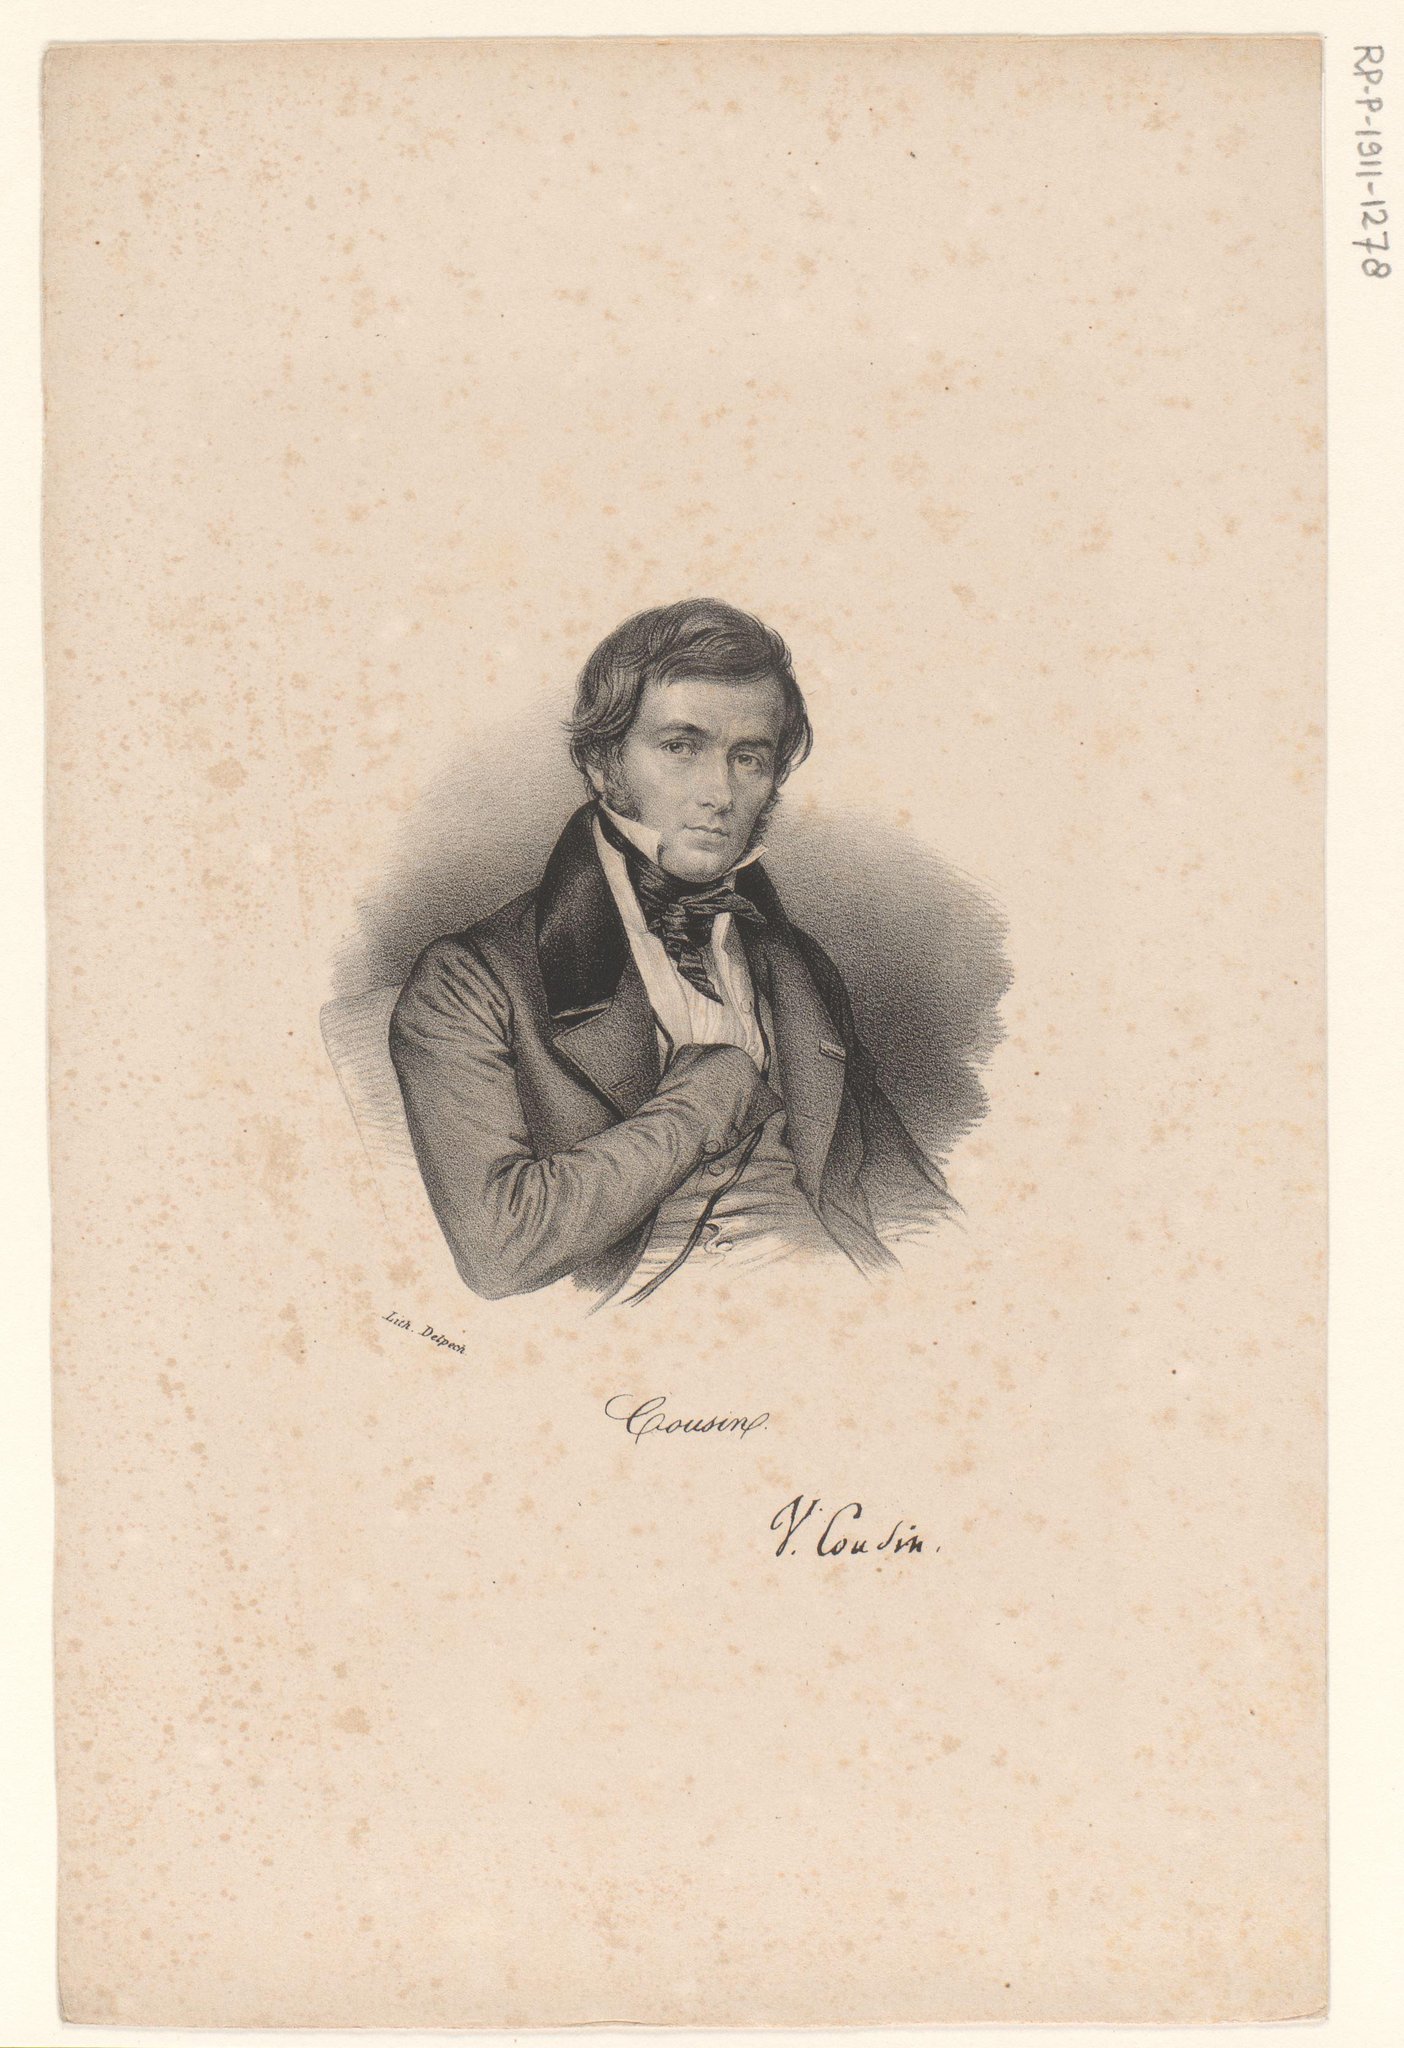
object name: print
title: Cousin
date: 1818-1842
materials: paper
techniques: lithograph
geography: paris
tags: paris, historical persons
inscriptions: collector's mark: Lugt 2228a